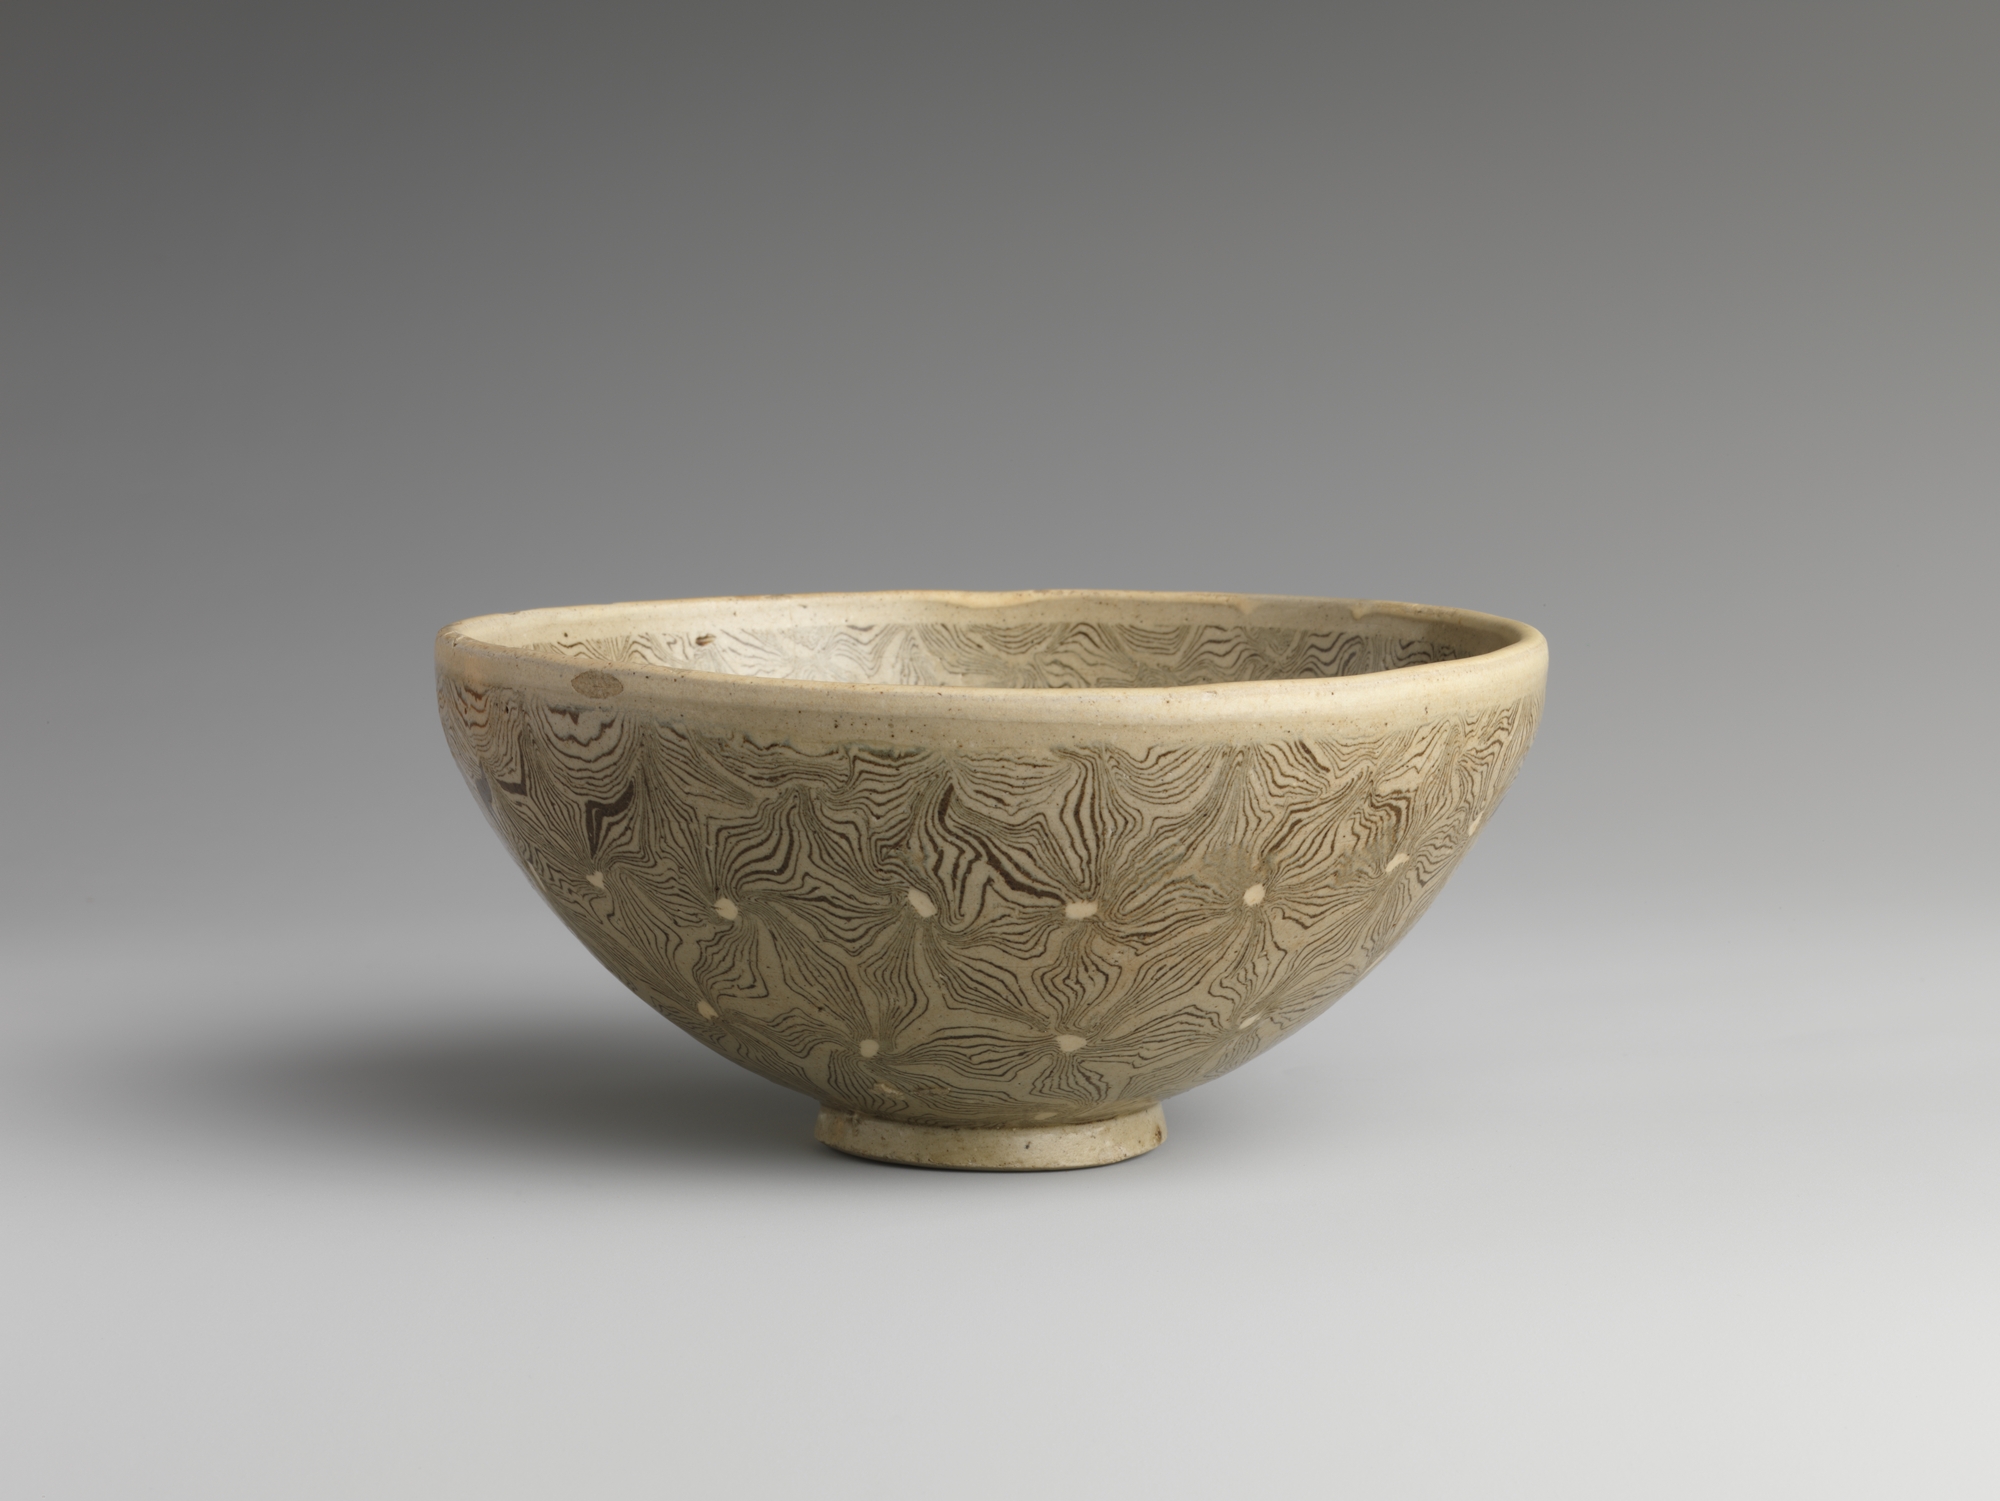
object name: tea bowl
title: Tea Bowl with Marbleized Veneer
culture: chinese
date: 1101-1300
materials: earthenware, glaze